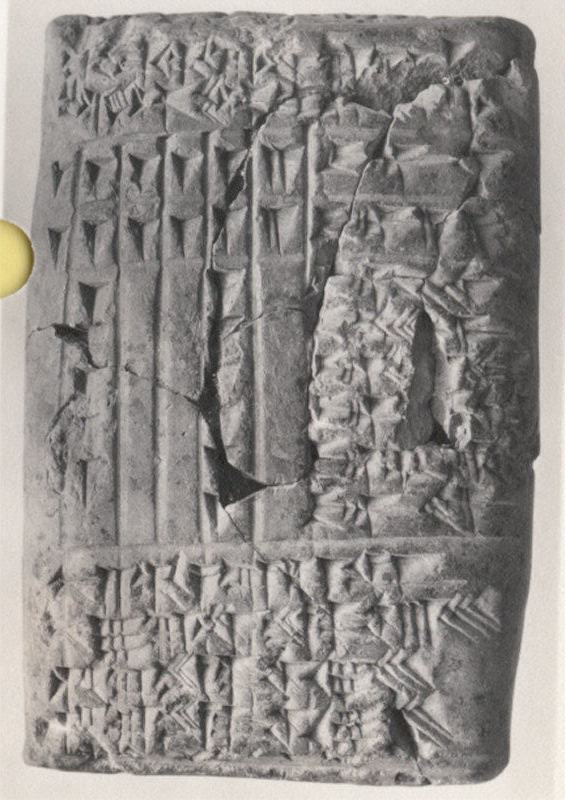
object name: cuneiform tablet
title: Cuneiform tablet: account of delivery of animals for offering, Ebabbar archive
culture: babylonian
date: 609 BCE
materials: clay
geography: mesopotamia